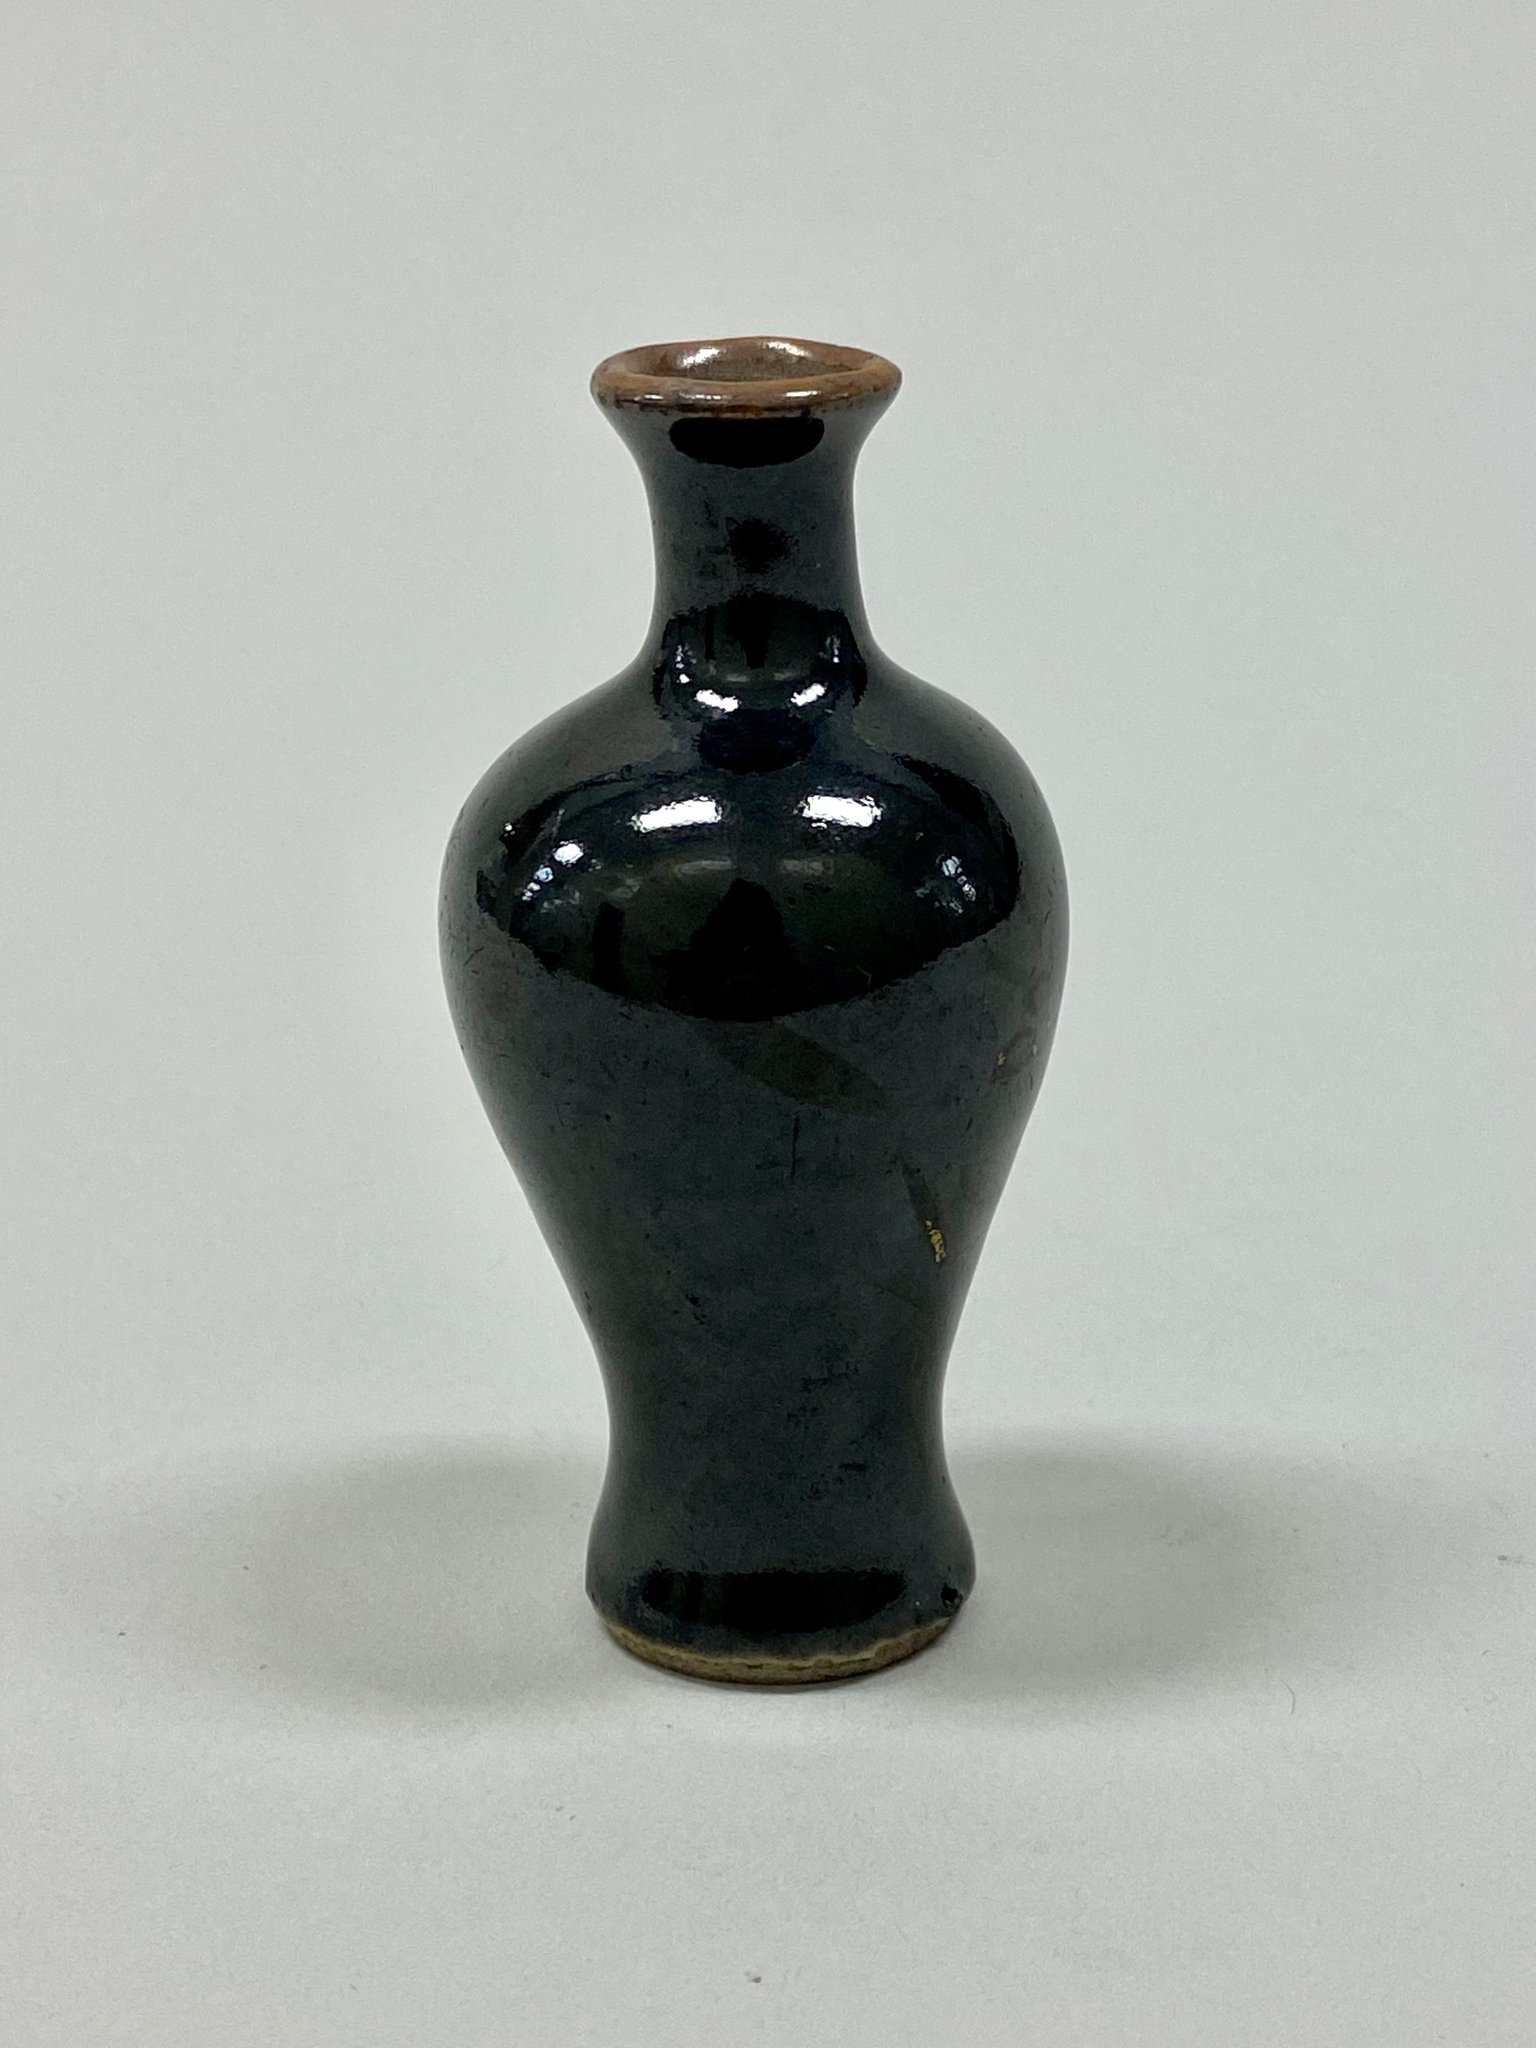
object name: vase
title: Miniature vase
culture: chinese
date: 1801-1900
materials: gilt, glaze, porcelain